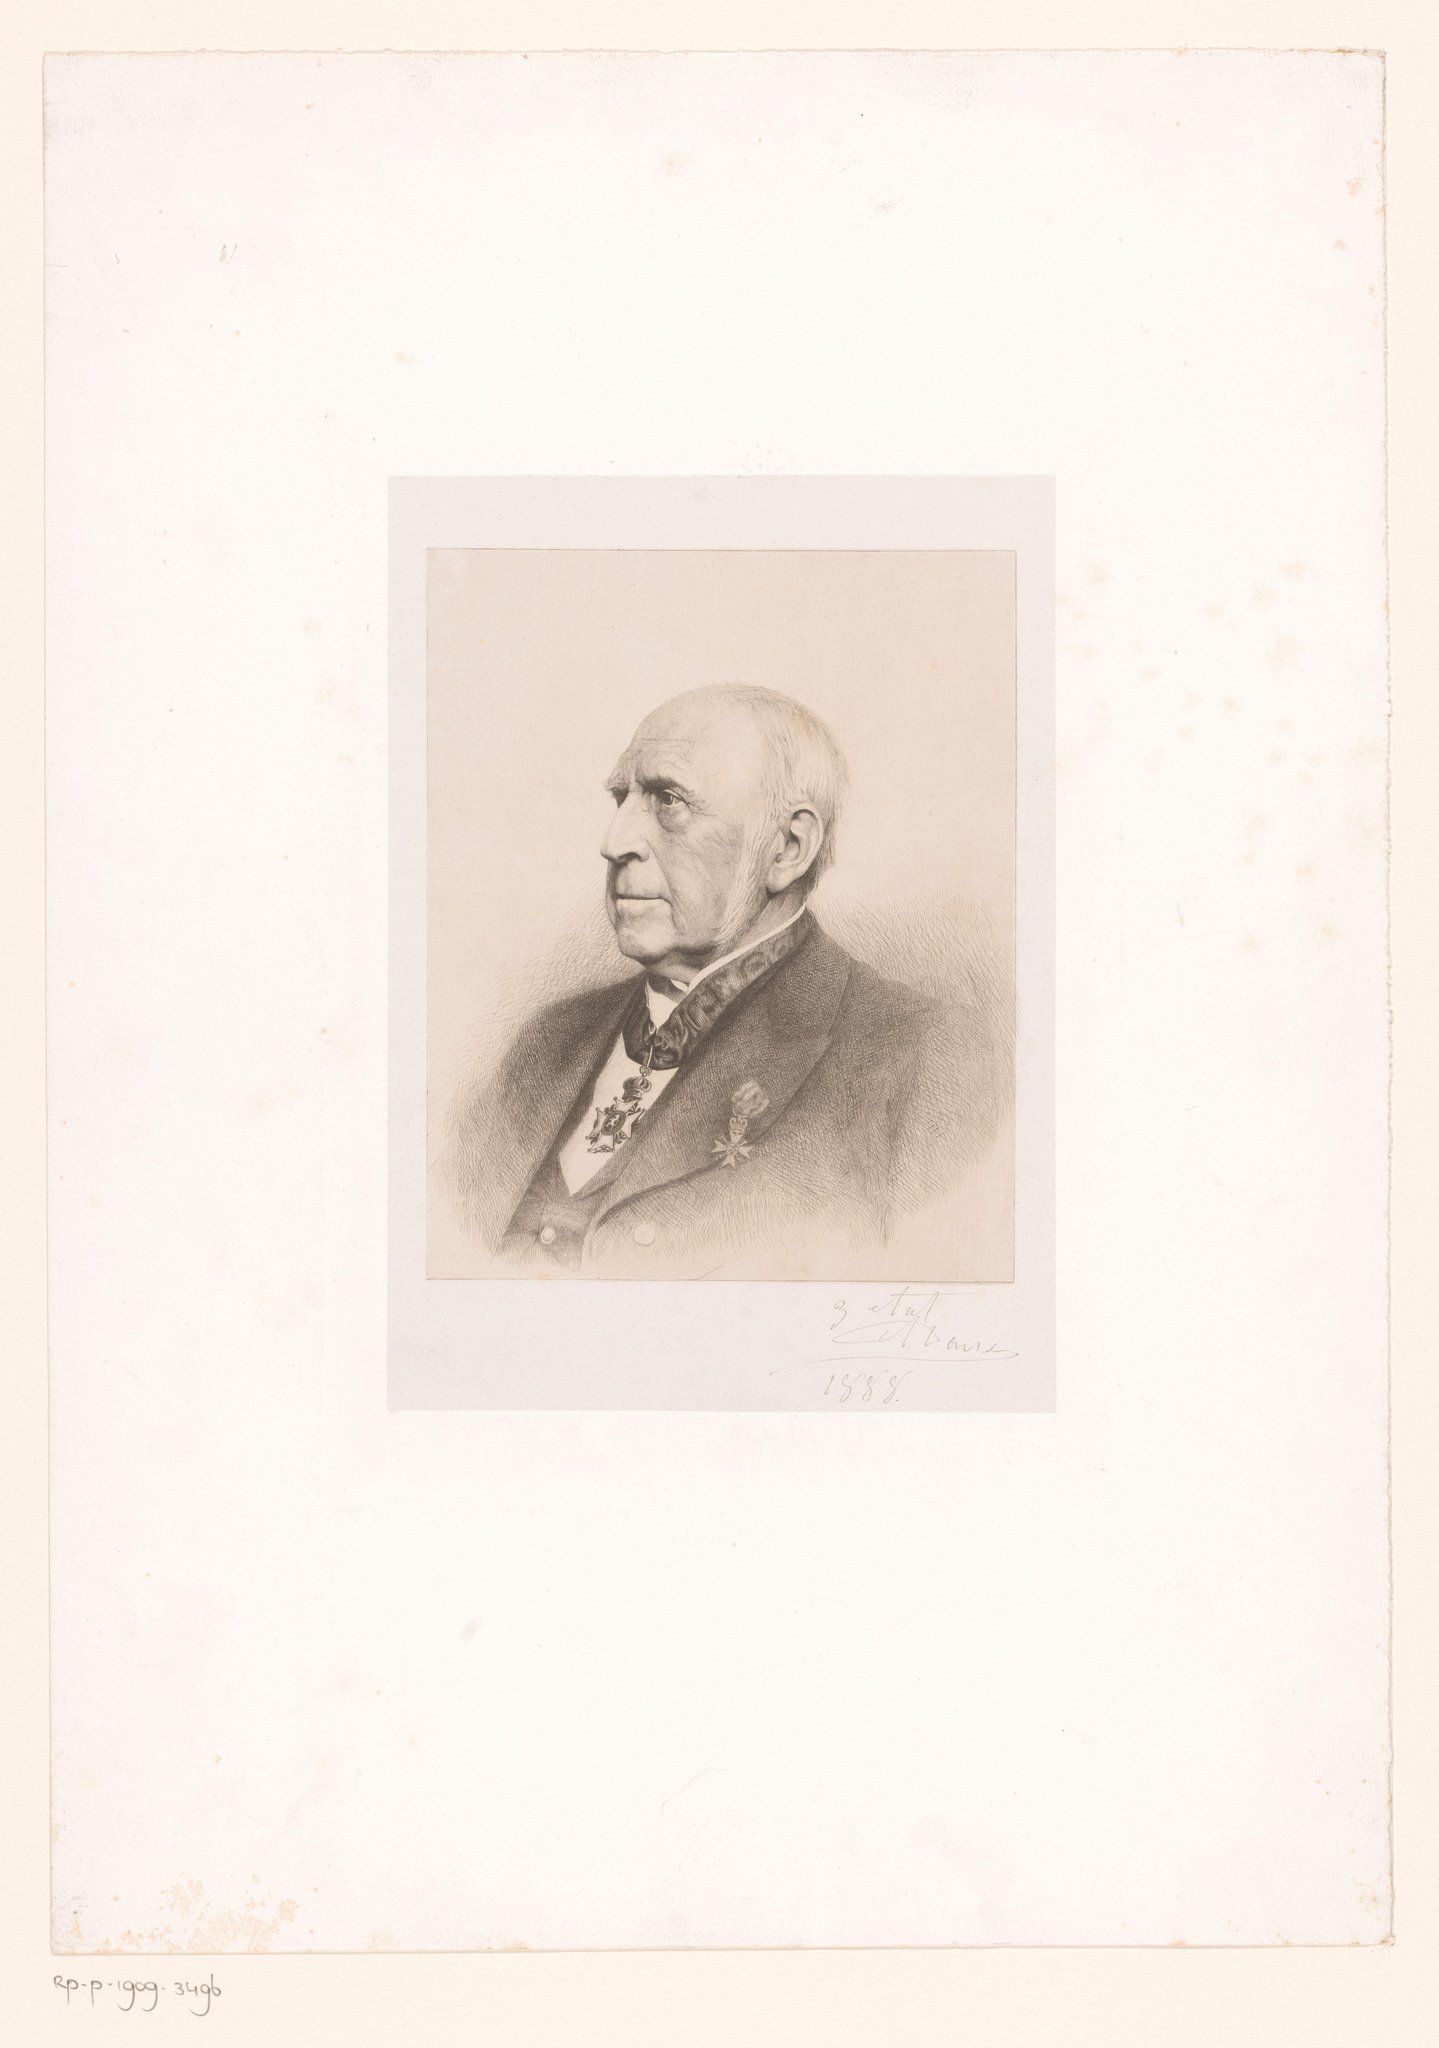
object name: print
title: Portret van een onbekende man, mogelijk Deville, directeur van de mijnbouwschool te Mons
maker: auguste danse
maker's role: print maker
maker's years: 1829-1929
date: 1888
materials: paper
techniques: etching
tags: anonymous historical person portrayed alone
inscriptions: annotation: ‘3 etat’, collector's mark: Lugt 2228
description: Het verschil tussen de derde en vierde staat is miniem en bestaat voornamelijk uit de toevoeging van het kader om de afbeelding.